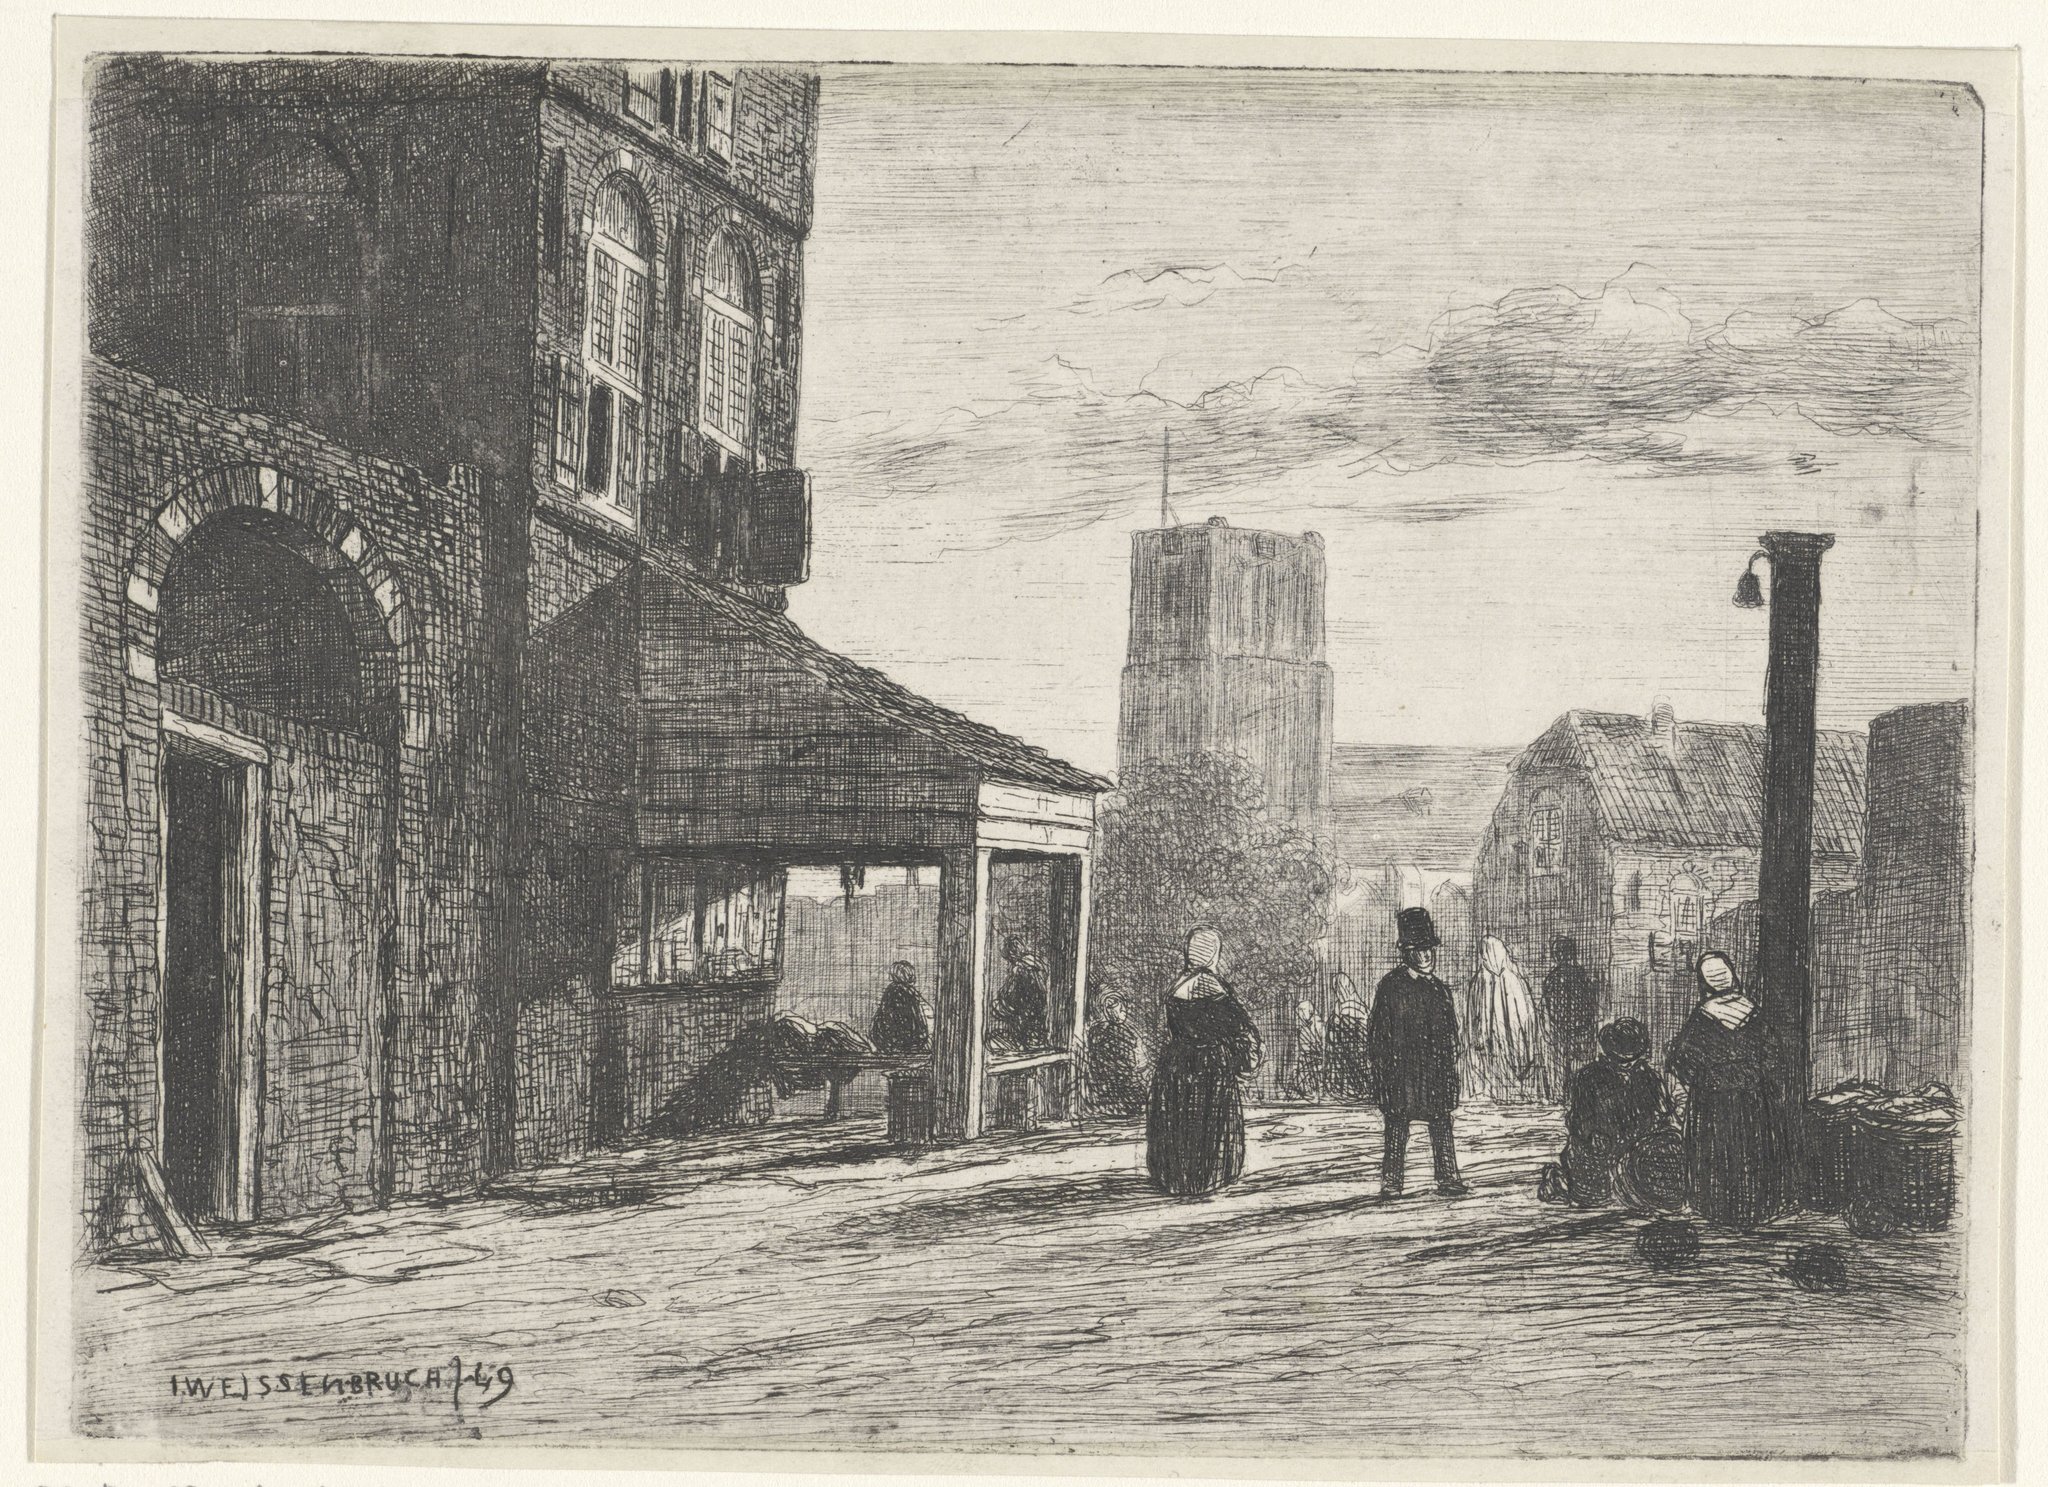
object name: print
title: Gezicht op de Sint-Martinuskerk te Woudrichem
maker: jan weissenbruch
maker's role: painter, print maker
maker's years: 1822-1880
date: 1849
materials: paper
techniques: etching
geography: the hague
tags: urban housing, adult woman, adult man, container made of plant material other than wood: basket, church (exterior), parts of church exterior and annexes, village square, place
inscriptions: collector's mark: Lugt 2228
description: Aan een dorpsplein staan enkele huizen. Rechts bevinden zich enkele figuren met manden rondom een paal met een lantaarn of een bel. In de verte is de Sint-Martinuskerk te zien.